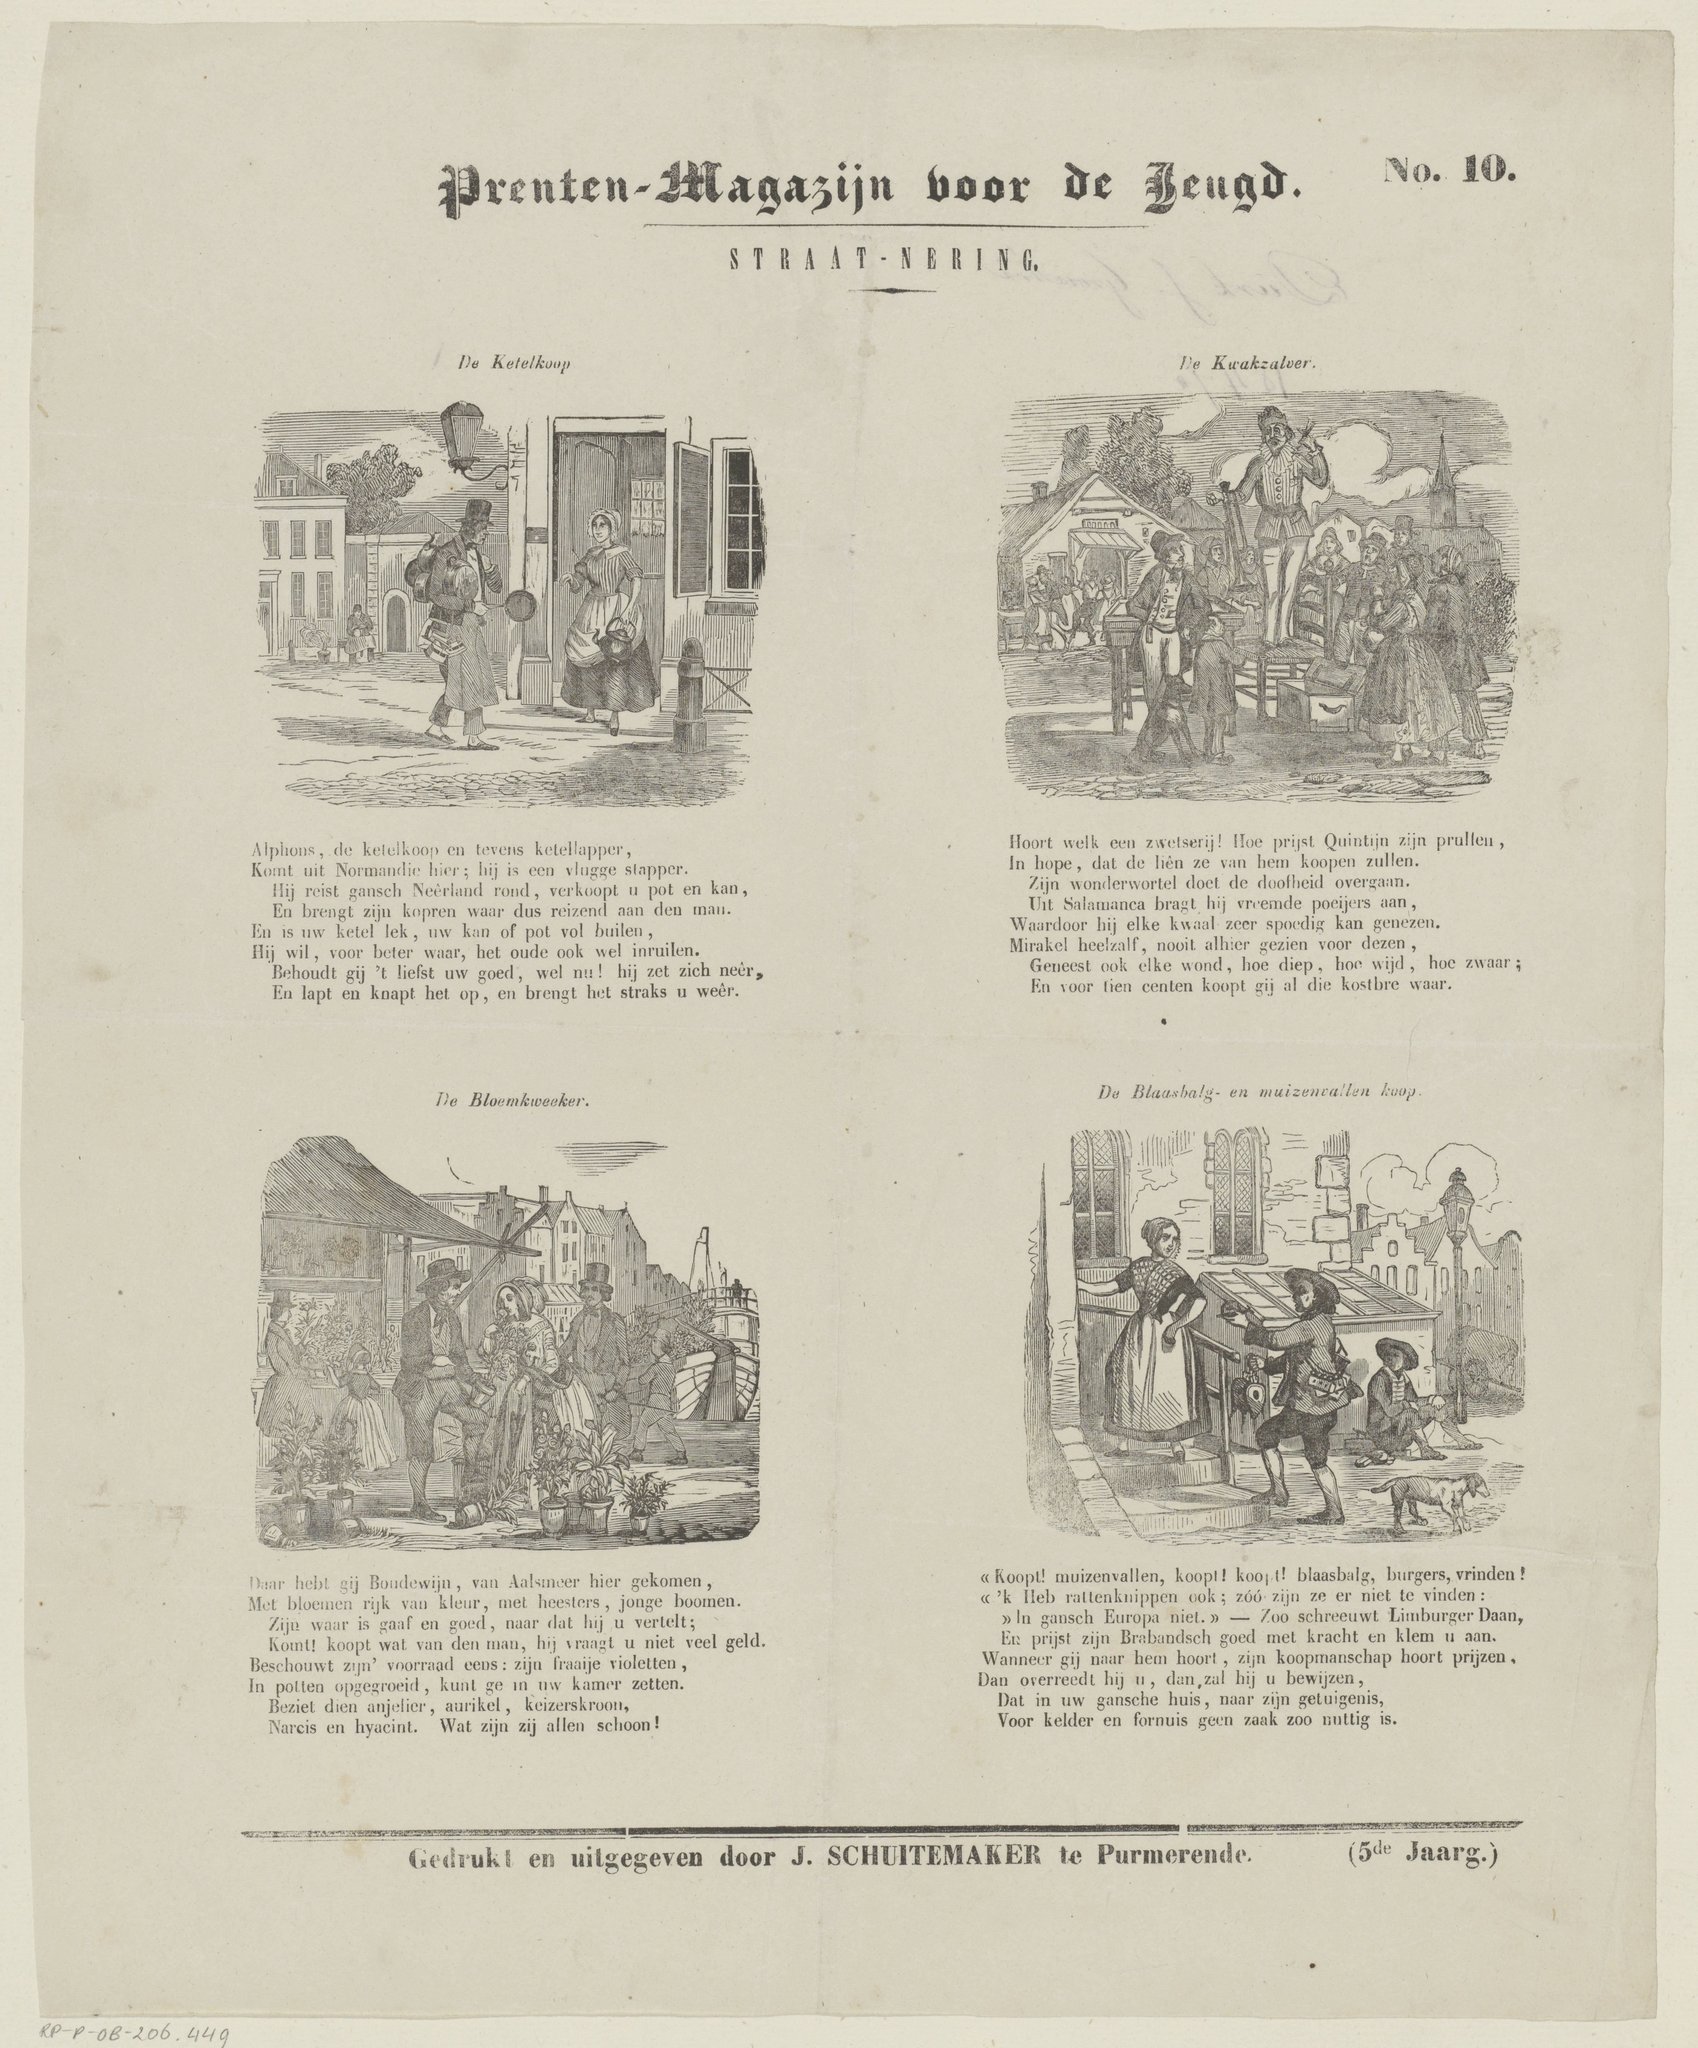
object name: print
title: Straat-nering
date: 1846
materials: paper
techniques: letterpress printing, engraving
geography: purmerend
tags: street-trader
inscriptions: collector's mark: Lugt 2760, inscription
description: Blad met 4 voorstellingen van straatverkopers: een kwakzalver, een ketelverkoper, een blaasbalg- en muizenvallenverkoper en een verkoper van bloemen en planten. Boven elke afbeelding een titel, onder elke afbeelding een achtregelig vers. Genummerd rechtsboven: No. 10.